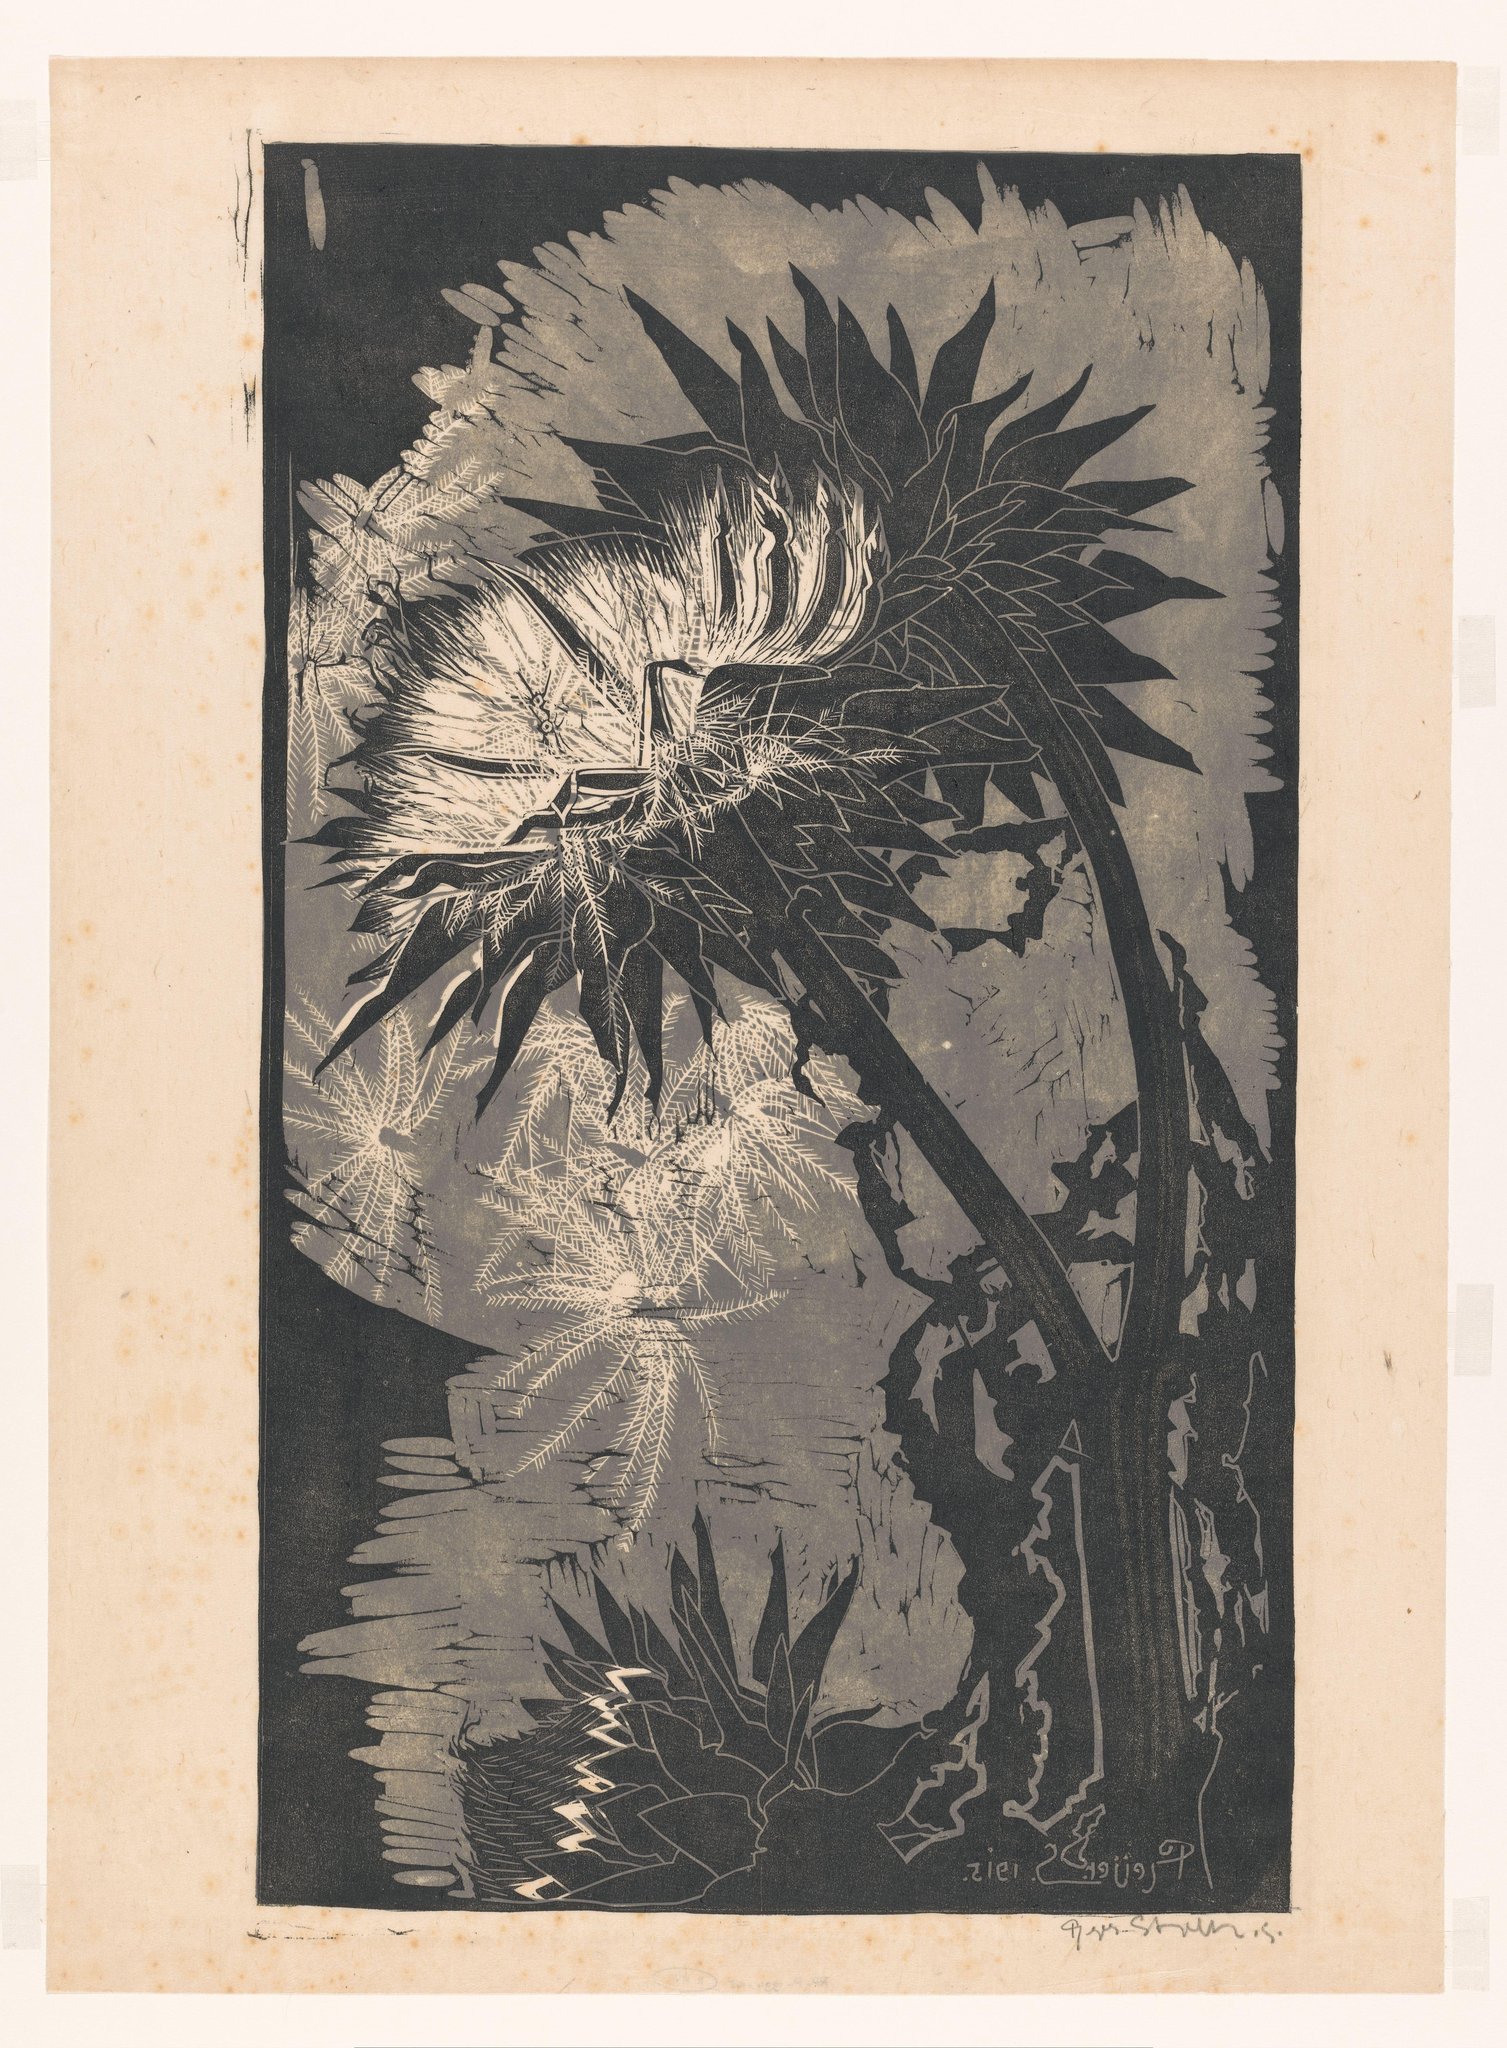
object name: print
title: Artisjok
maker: reijer stolk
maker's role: draughtsman, print maker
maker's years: 1896-1945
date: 1915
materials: paper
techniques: linocut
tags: plants and herbs: artichoke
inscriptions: collector's mark: Lugt 2228